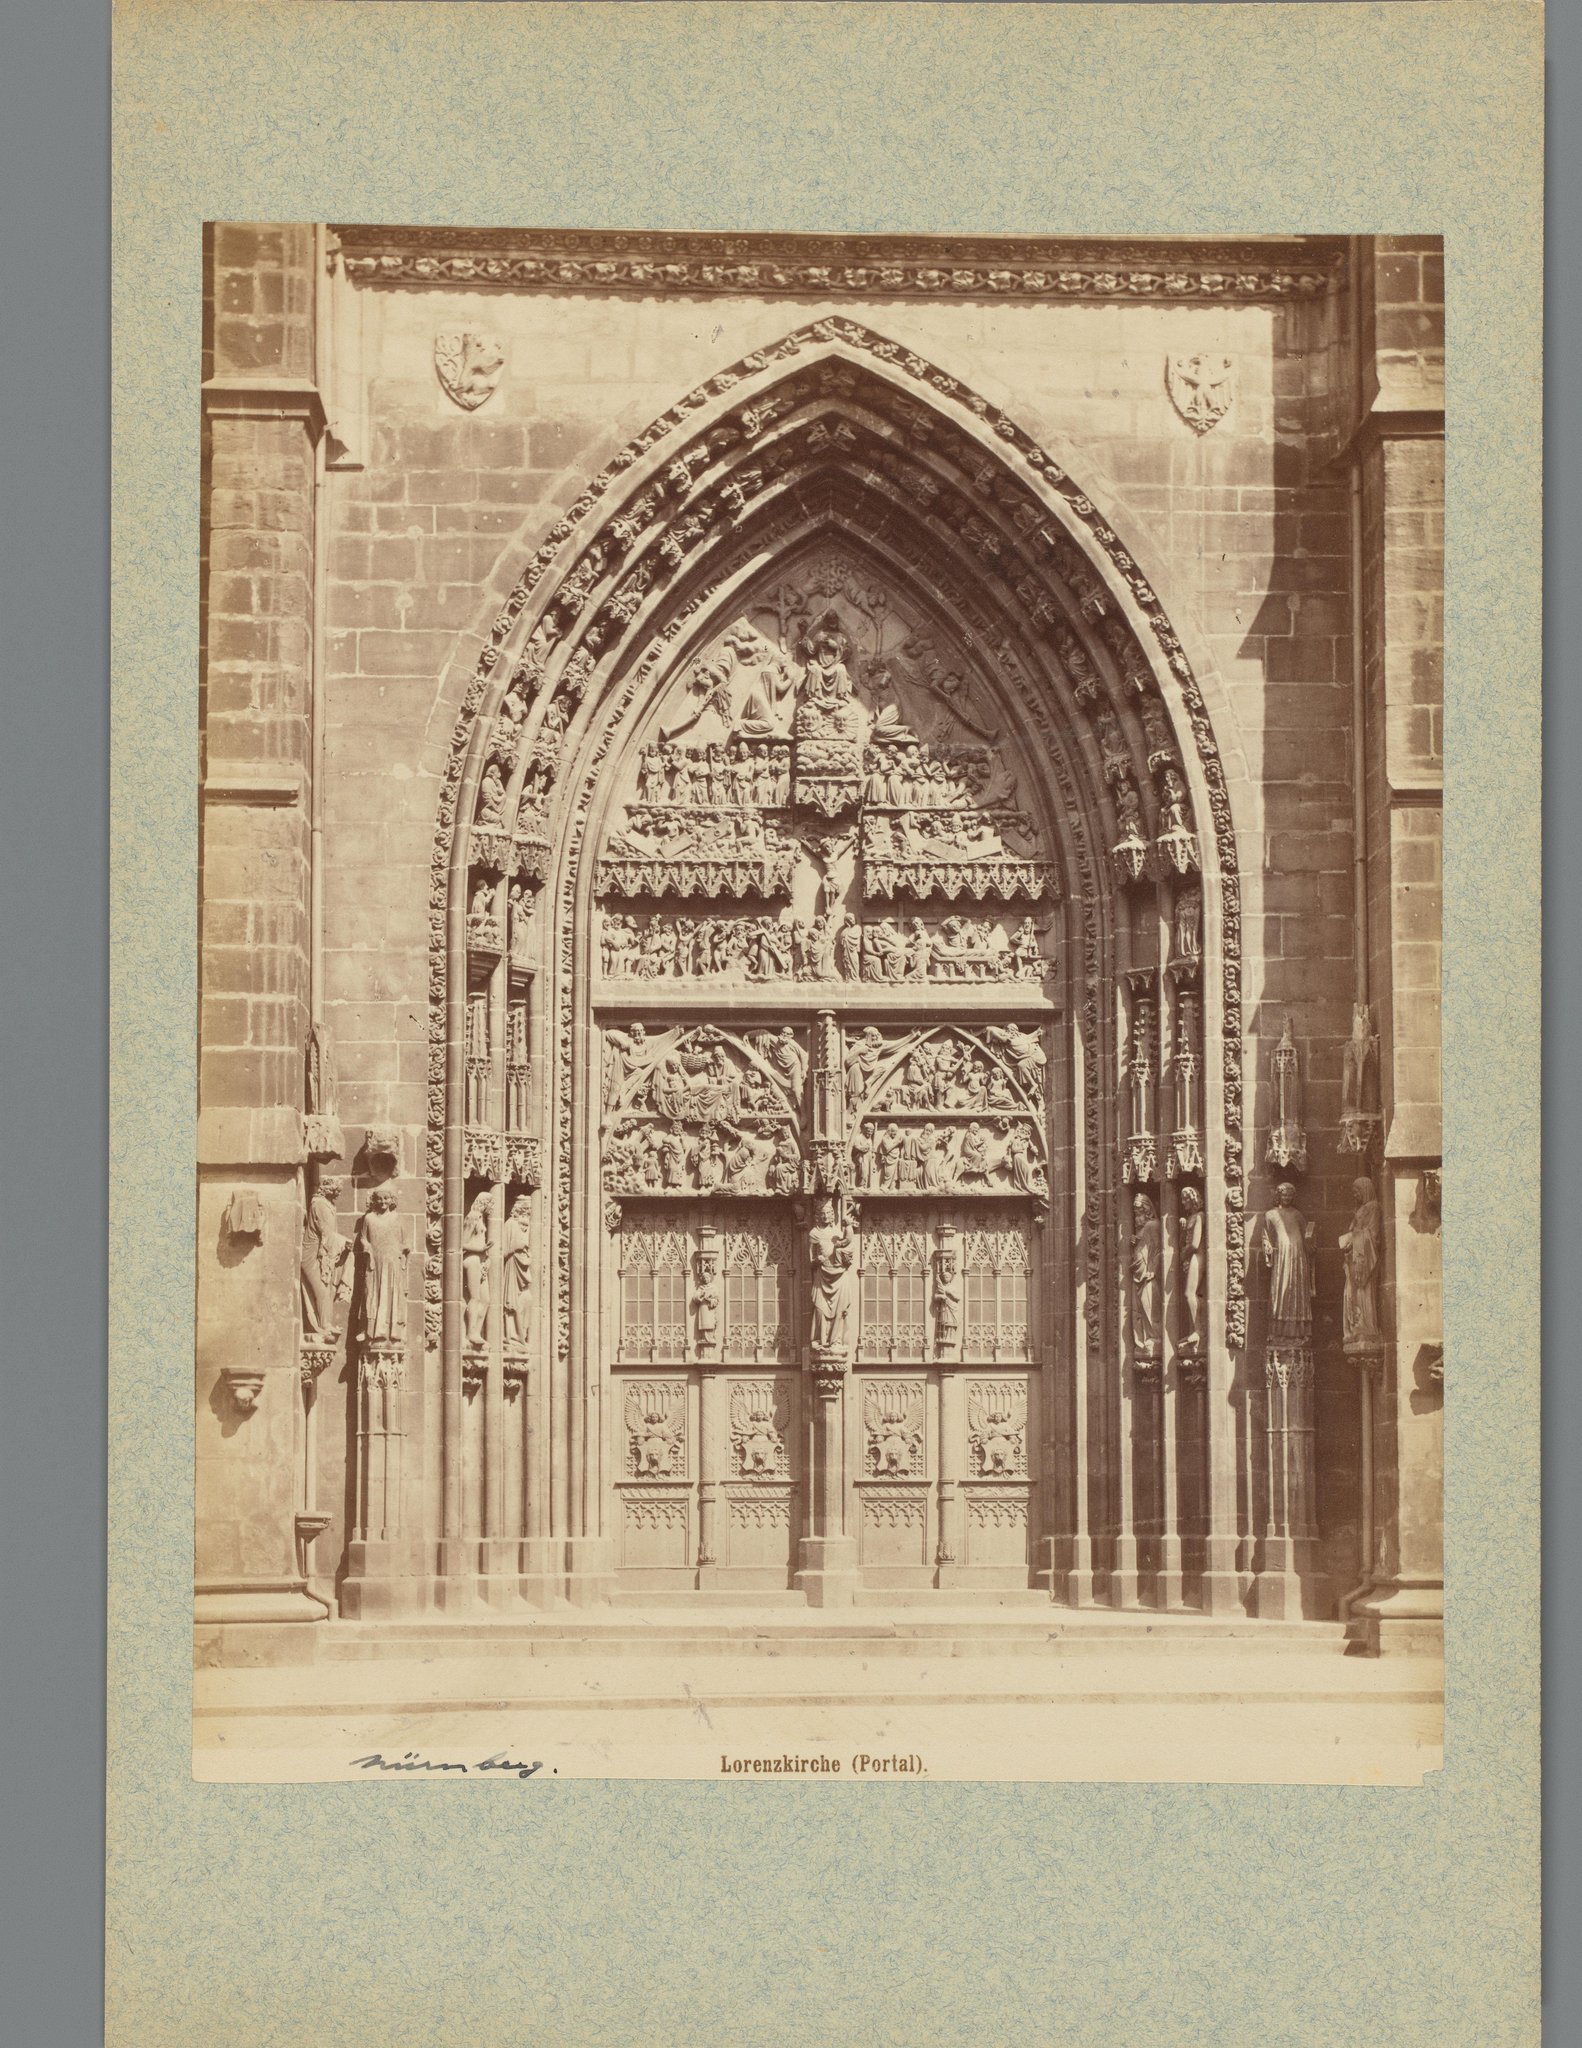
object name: photograph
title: Lorenzkirche Nürnberg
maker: Anonymous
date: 1850-1900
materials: cardboard, paper, photographic support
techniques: albumen print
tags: sint-laurentiuskerk